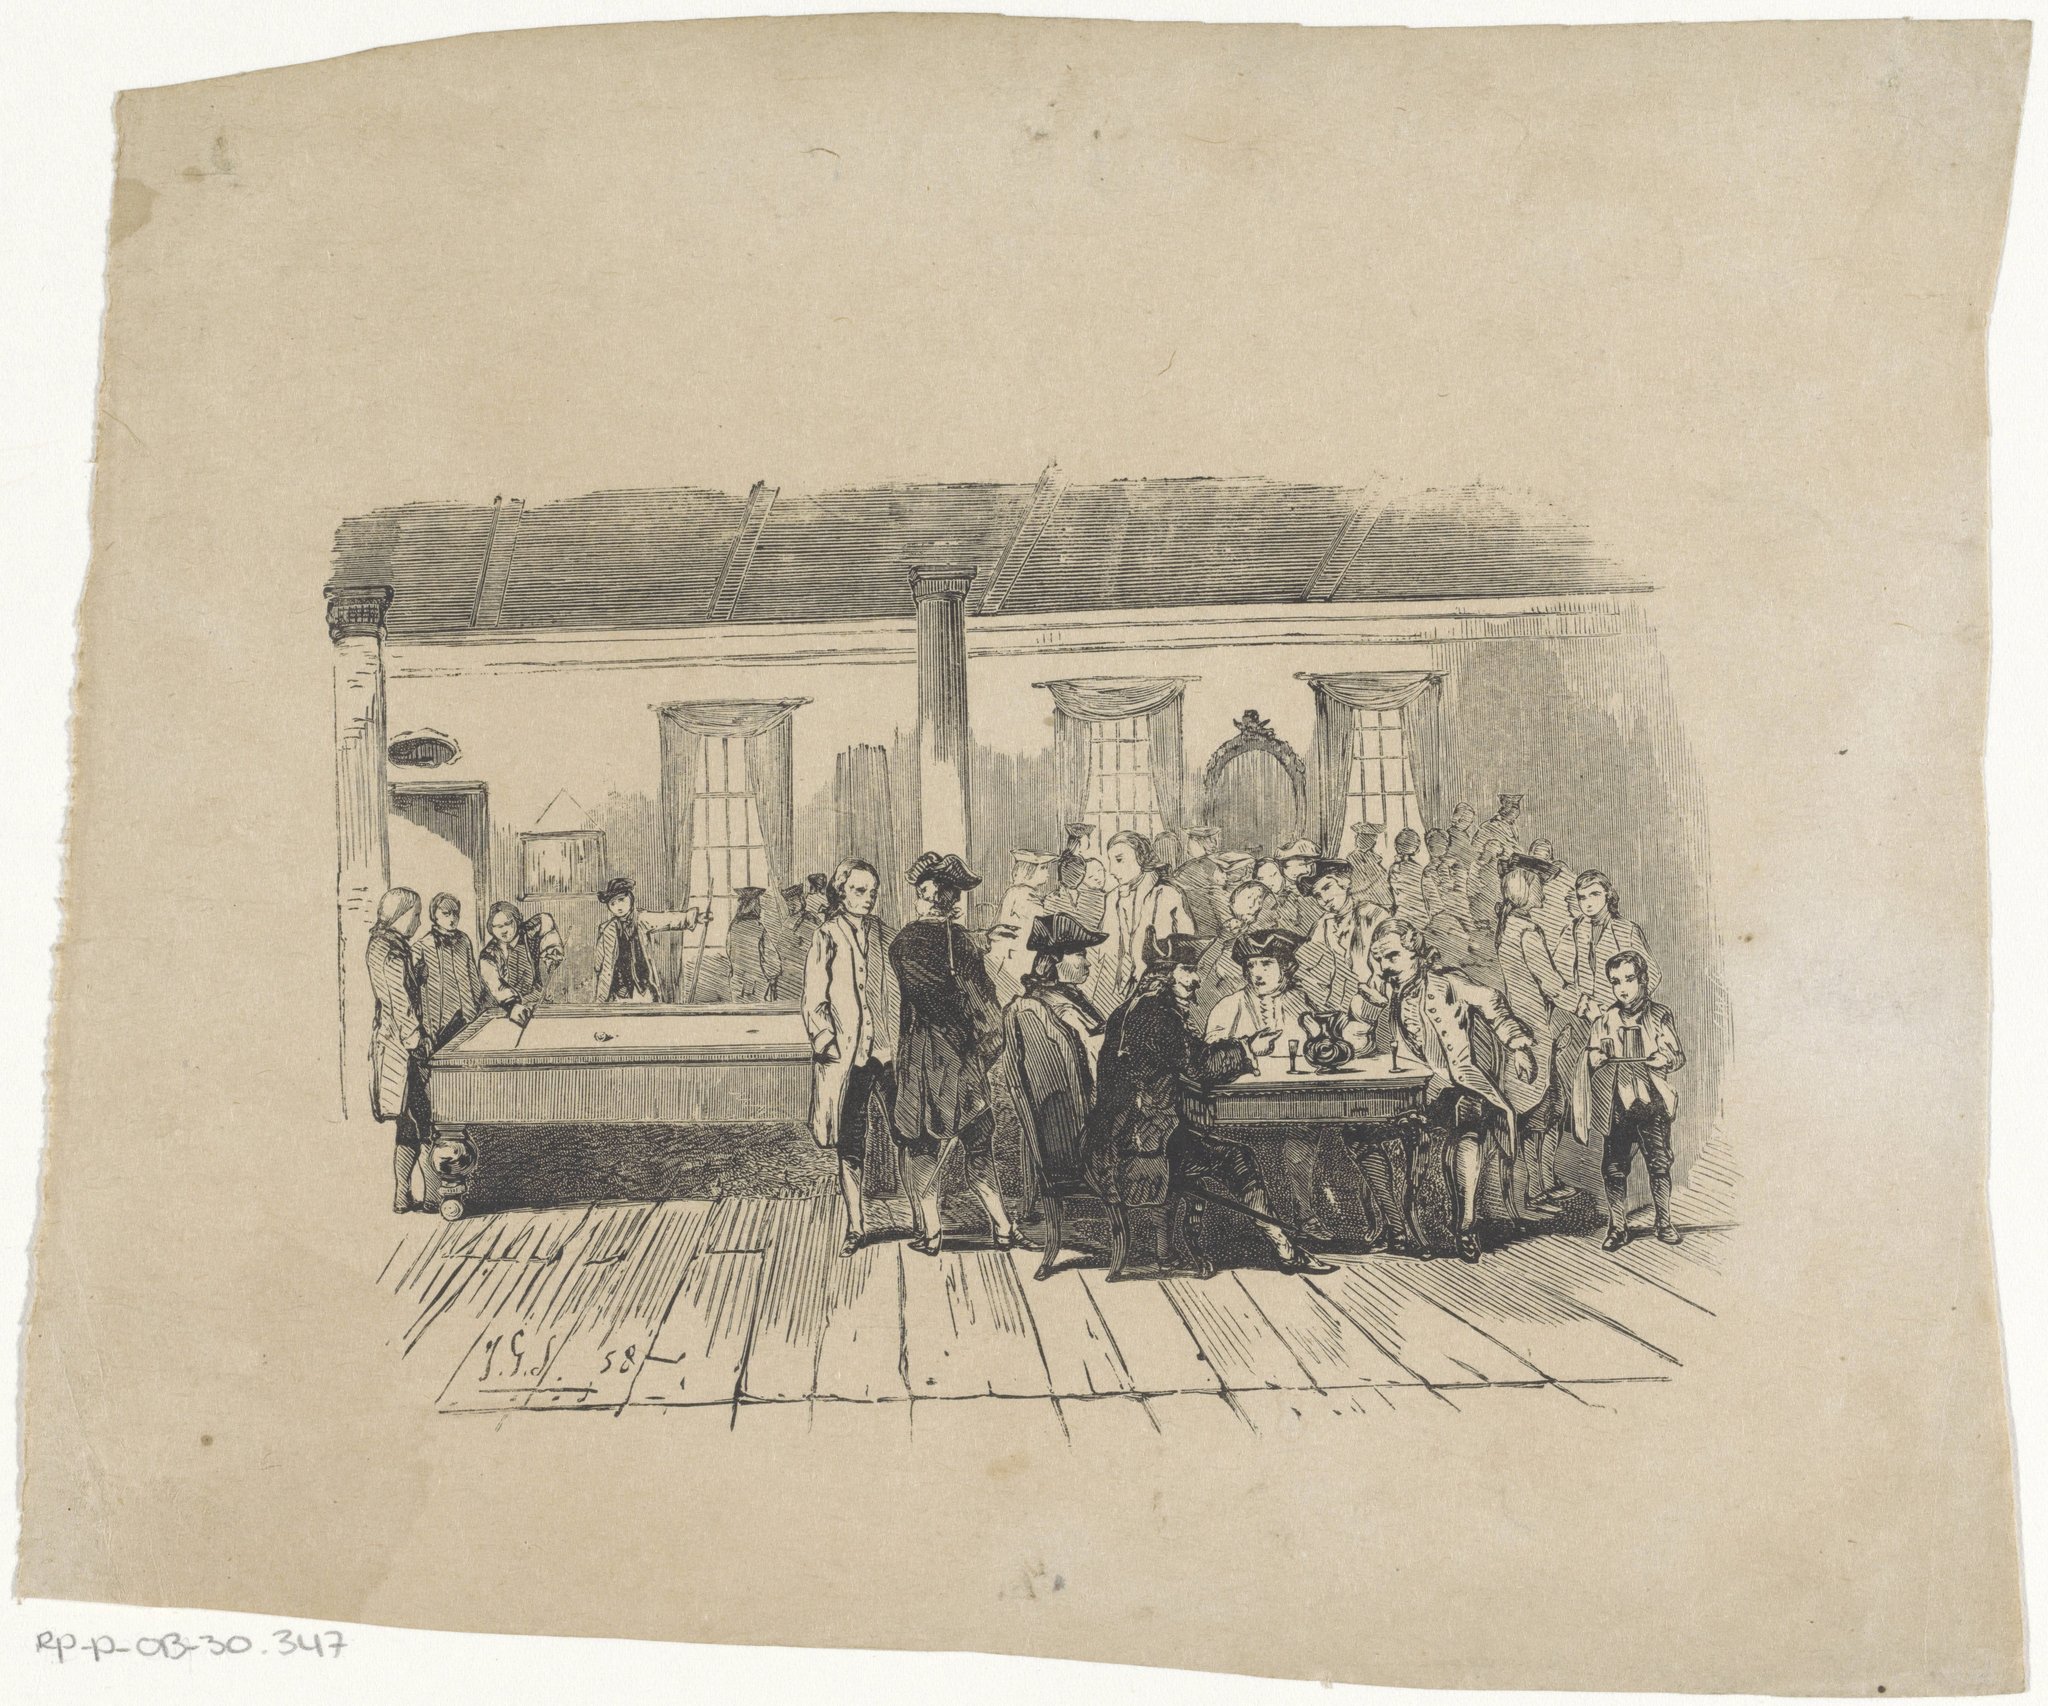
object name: print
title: Interieur met tientallen mannen en een biljarttafel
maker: jan gerard smits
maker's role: draughtsman, print maker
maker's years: 1823-1910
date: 1858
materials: paper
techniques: engraving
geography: the hague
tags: billiards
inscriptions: collector's mark: Lugt 2228